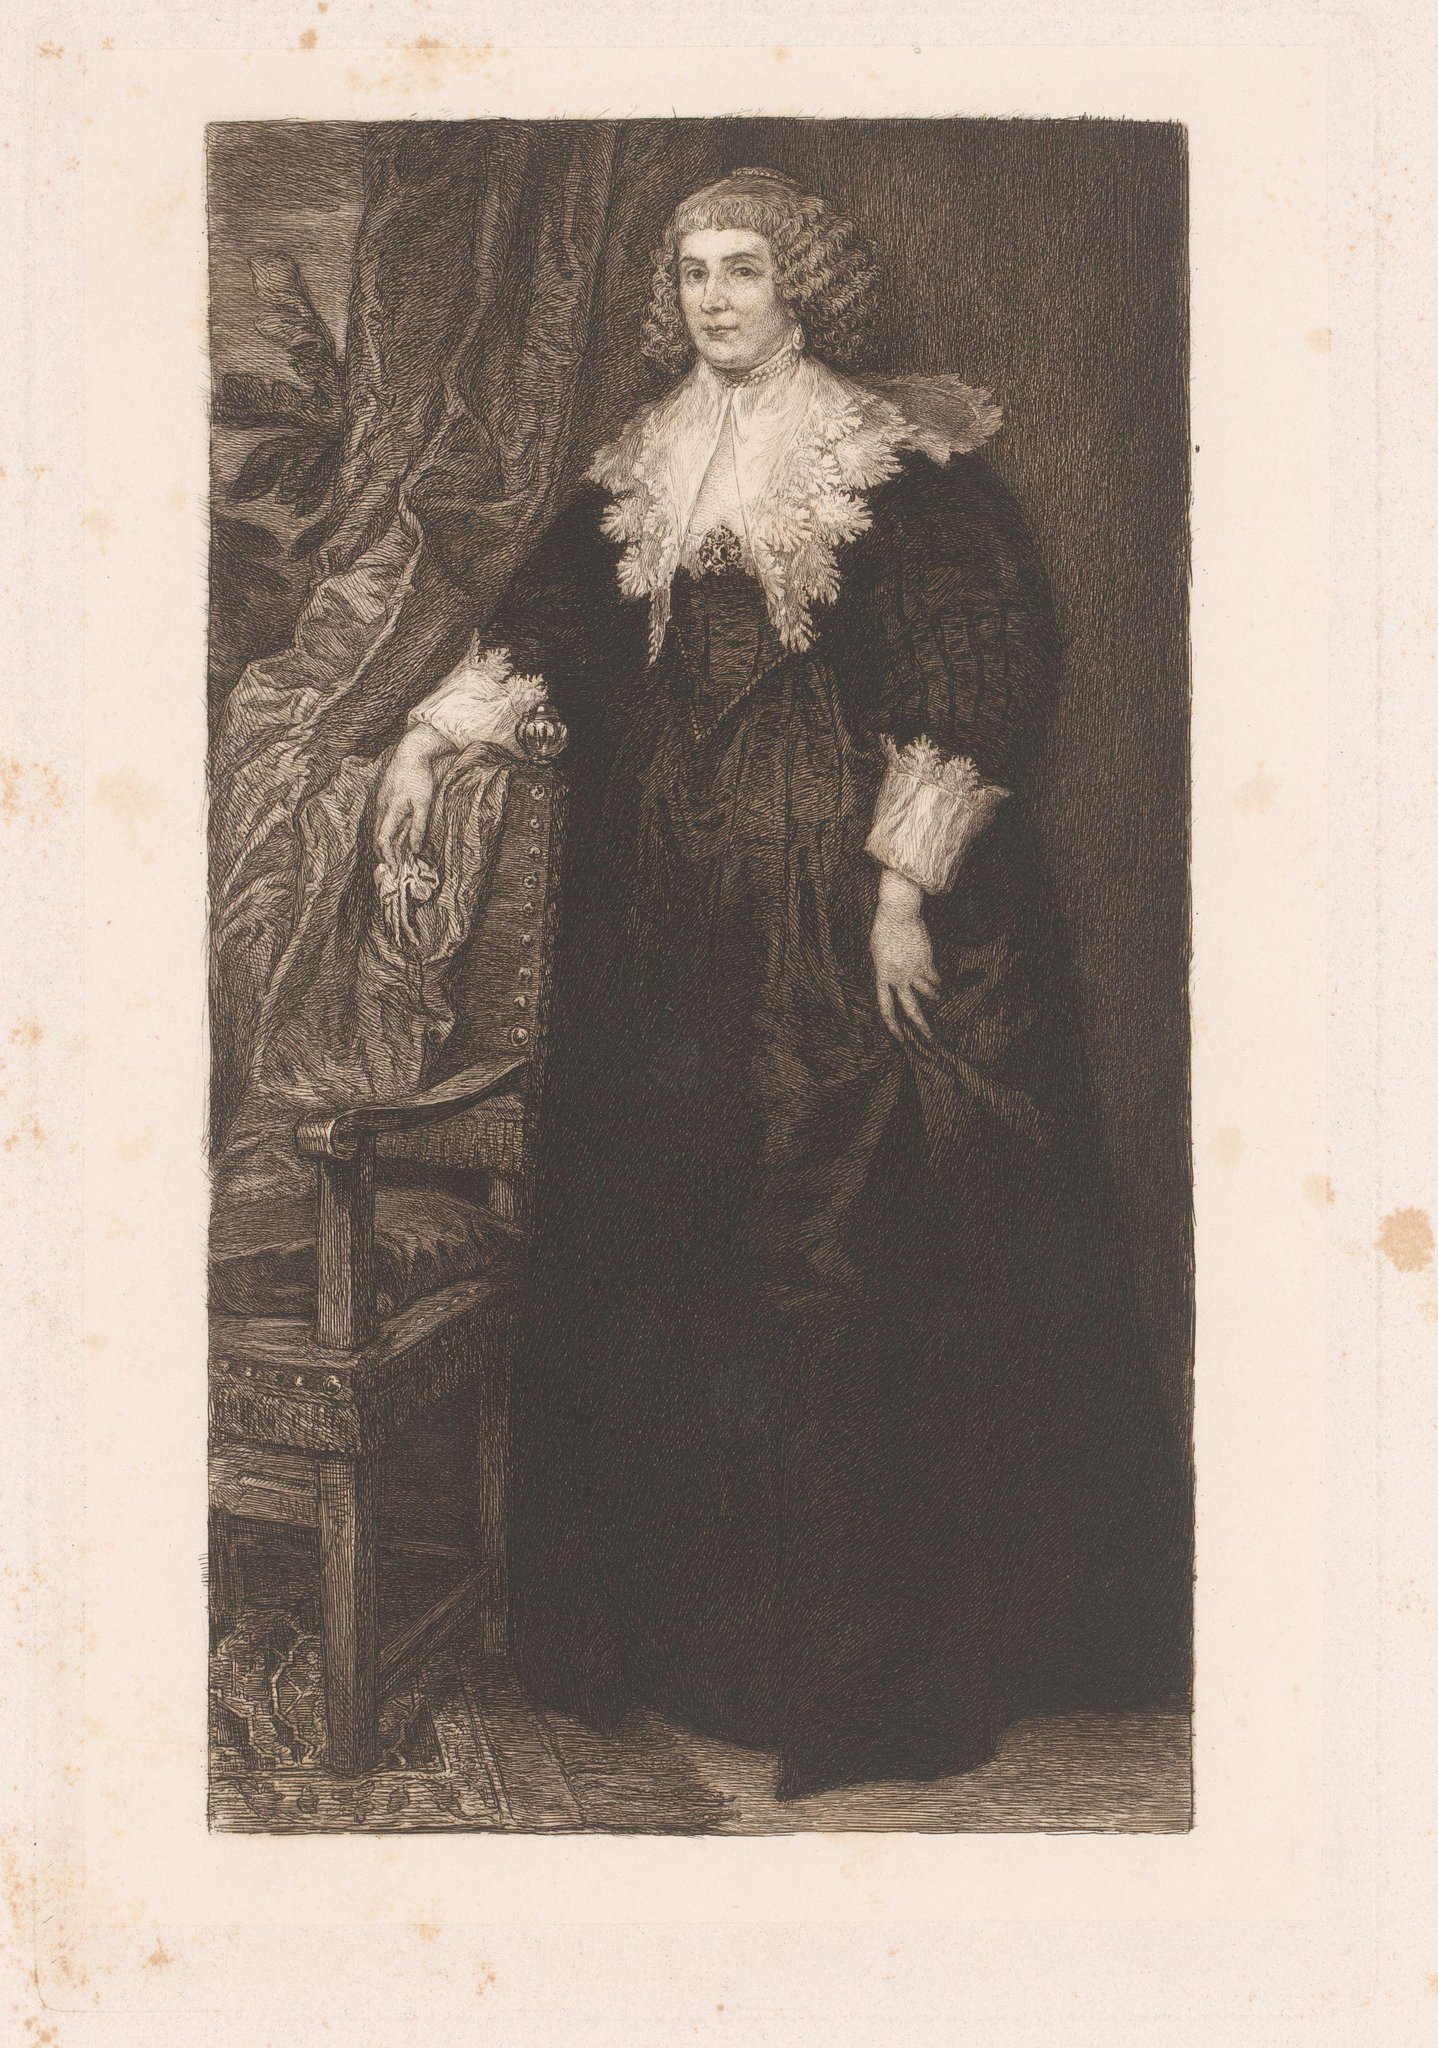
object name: print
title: Portret van Anna van Craesbecke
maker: william unger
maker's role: draughtsman, painter, print maker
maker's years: 1837-1932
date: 1847-1889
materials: paper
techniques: etching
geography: germany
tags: adult woman, historical persons, chair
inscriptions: collector's mark: Lugt 2228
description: Prent naar het schilderij door Anthony van Dyck in de Gemäldegalerie Alte Meister te Kassel (inv.nr. GK 129).